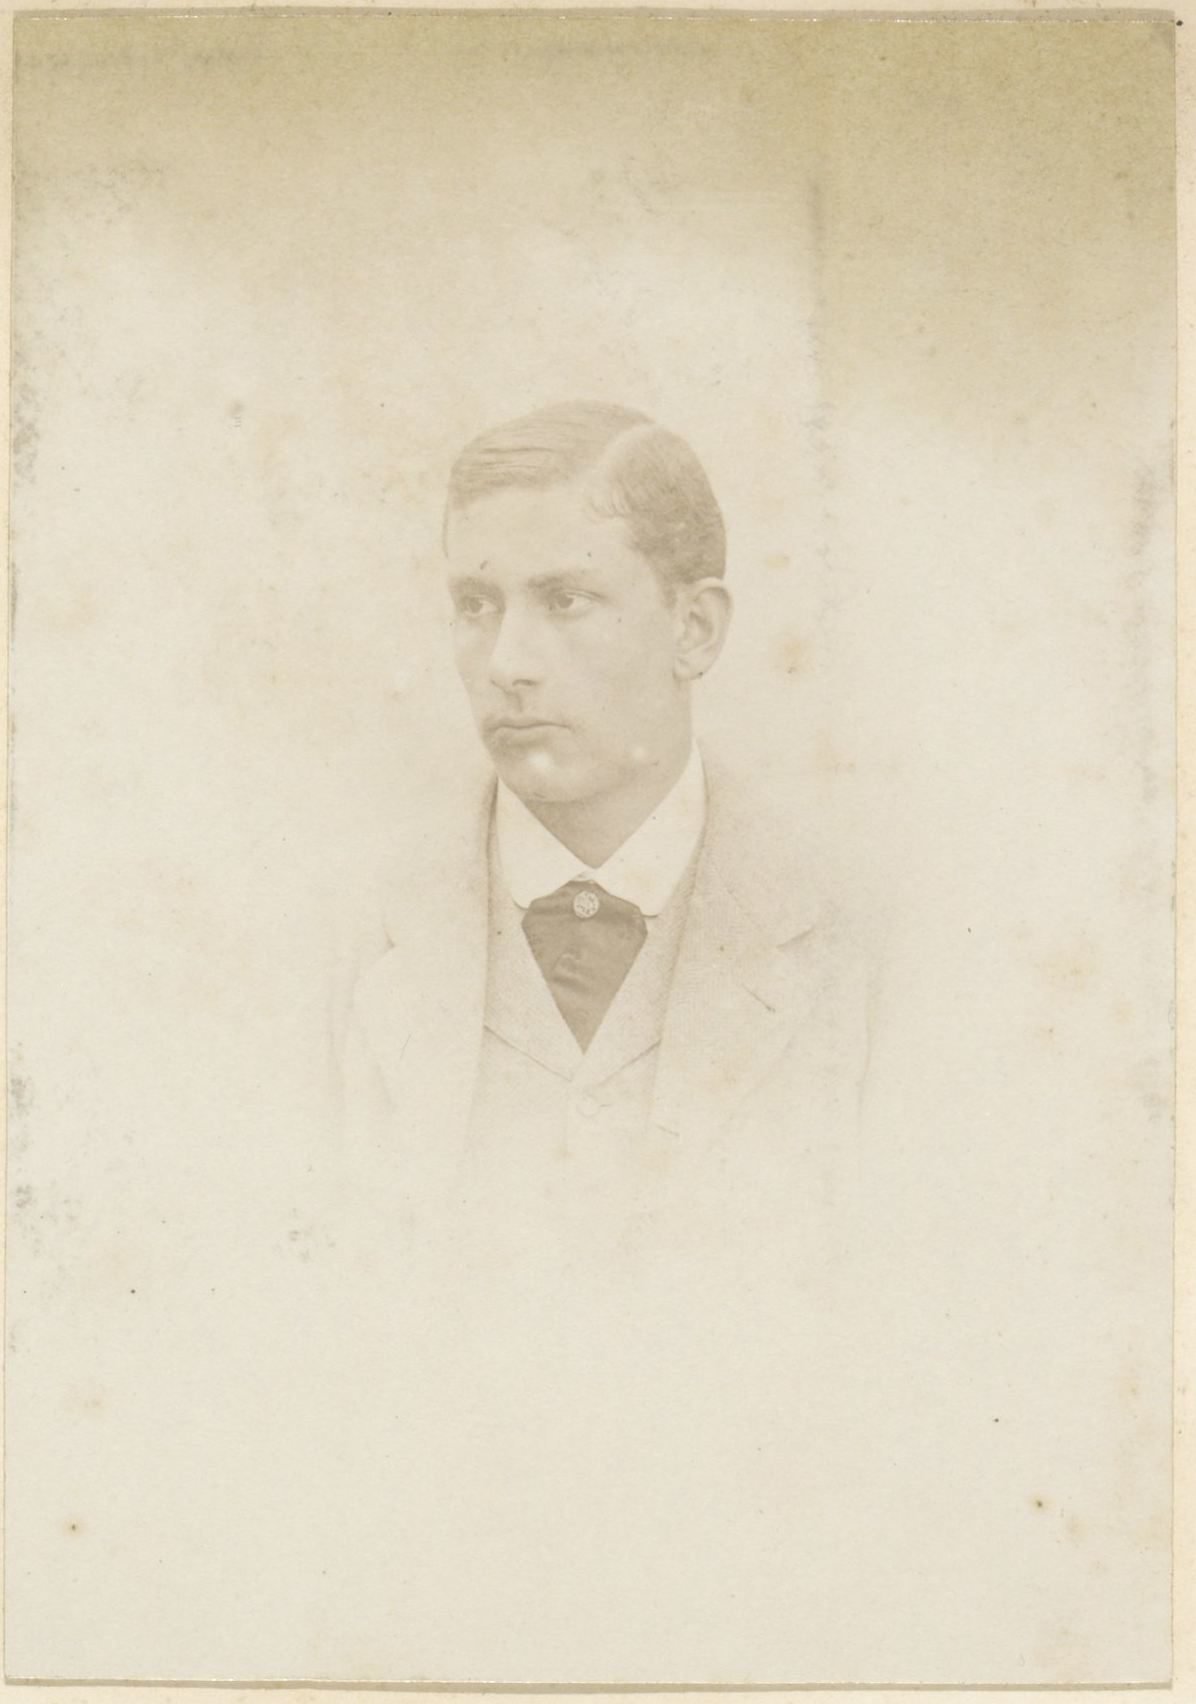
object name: photograph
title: Portret van een Franse man met een das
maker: Anonymous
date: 1900-1910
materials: paper, photographic support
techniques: albumen print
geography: france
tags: adult man, neck-gear ~ clothing, france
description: Onderdeel van Fotoalbum van een Franse amateurfotograaf met opnames van een familie, distilleerderij Delizy & Doistau Fils, het leger en bezienswaardigheden in Frankrijk.